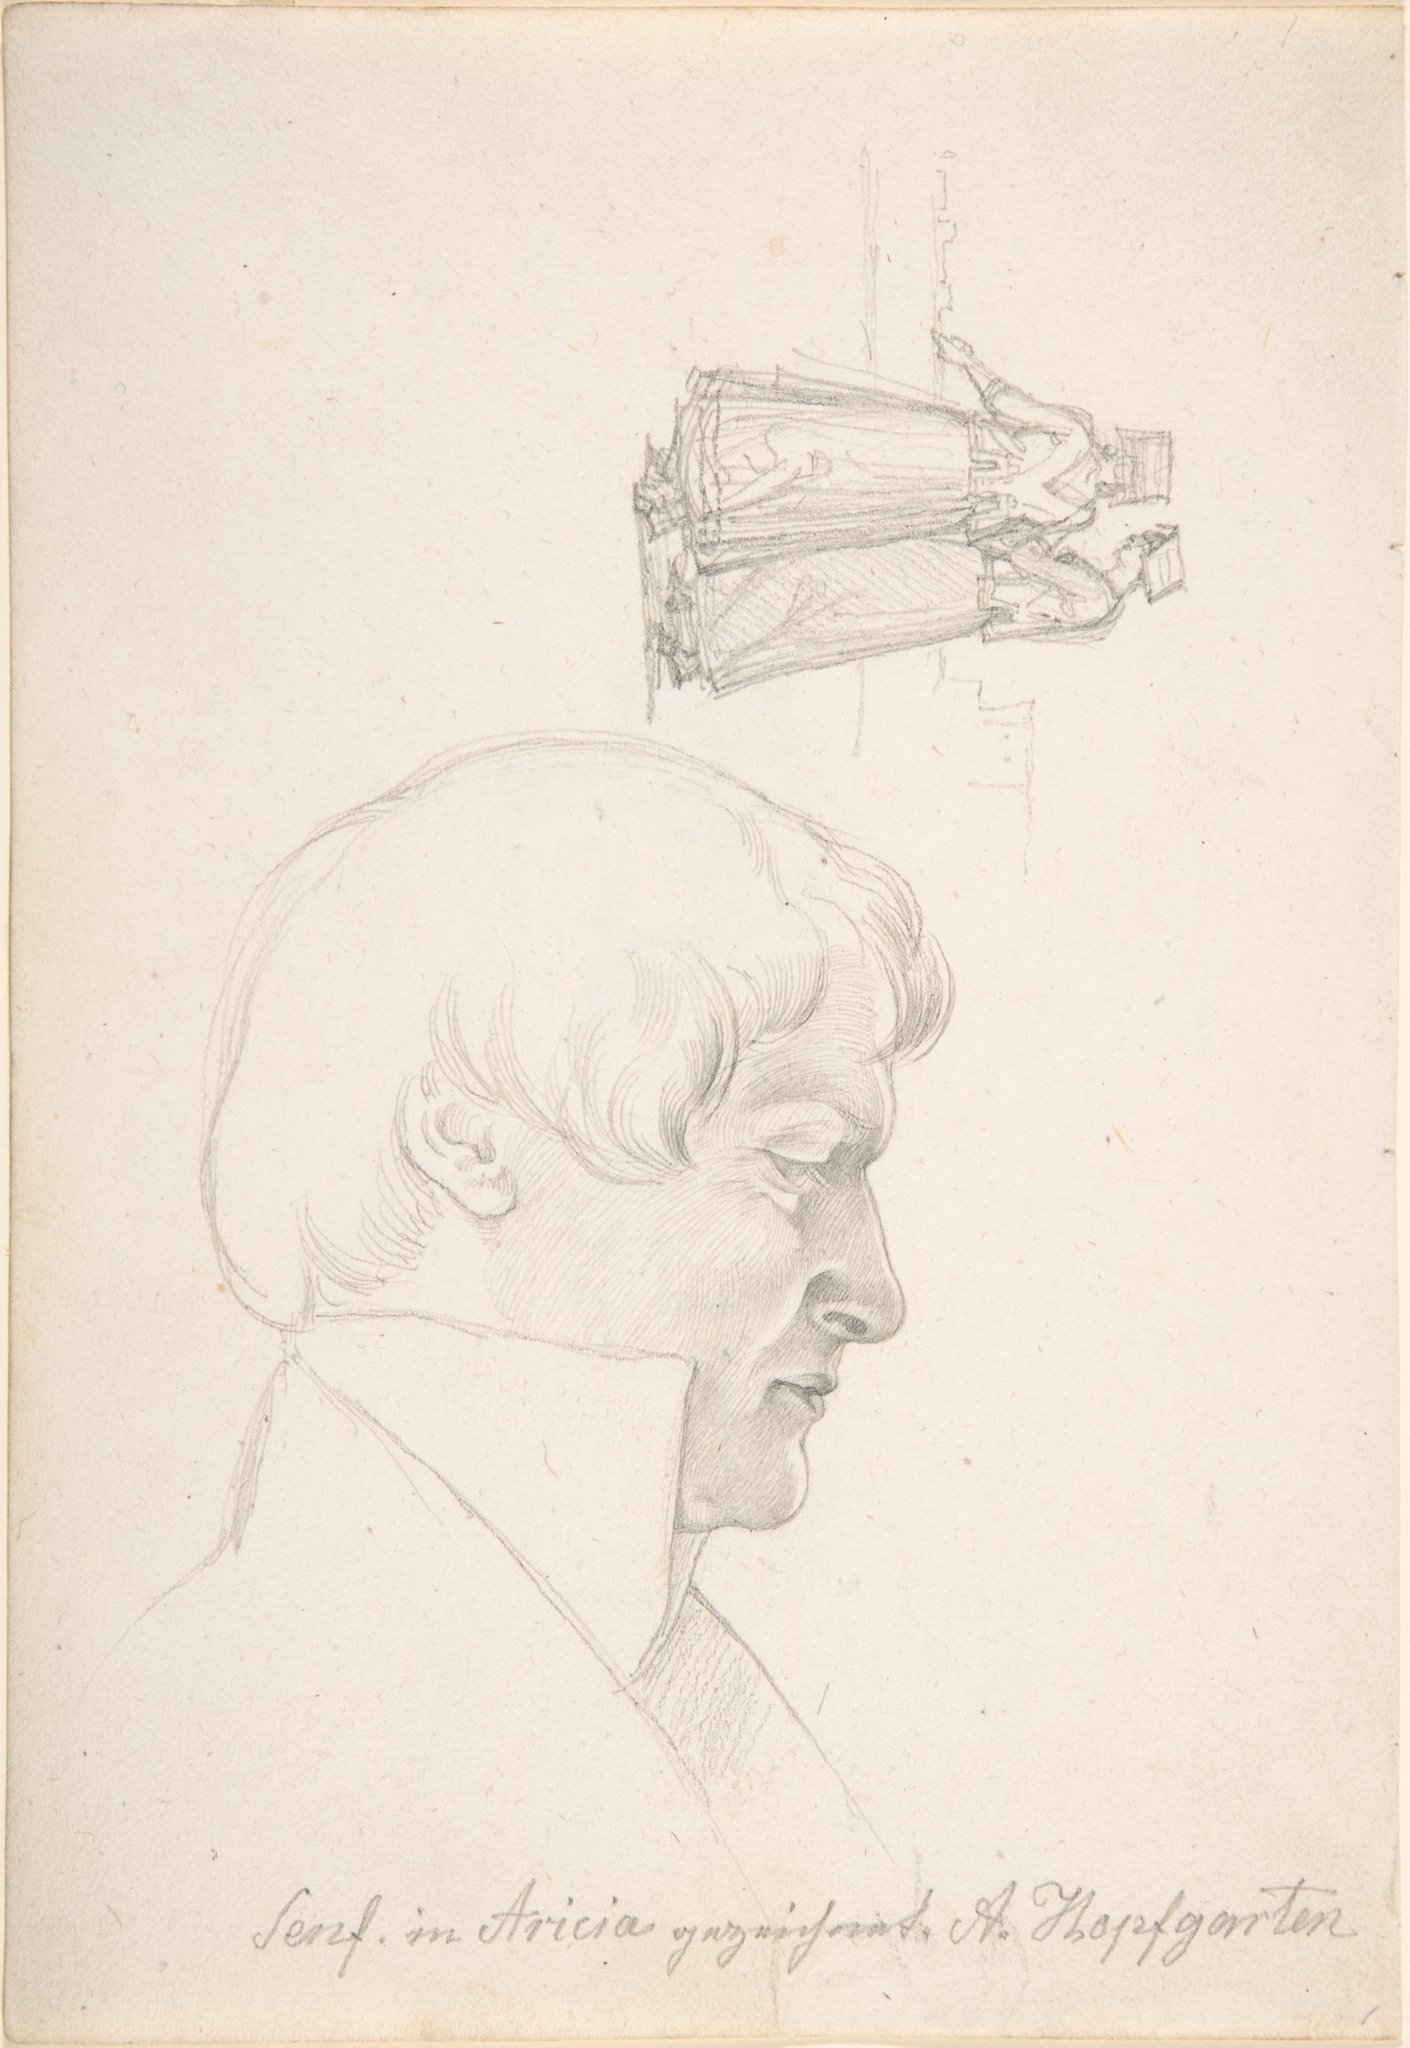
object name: drawing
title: Study Sheet with a Portrait of Carl Julius Senff and Two Italian Women Walking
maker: august ferdinand hopfgarten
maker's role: artist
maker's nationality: german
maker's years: 1807-1896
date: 1801-1900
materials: graphite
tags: men,profiles,women,walking